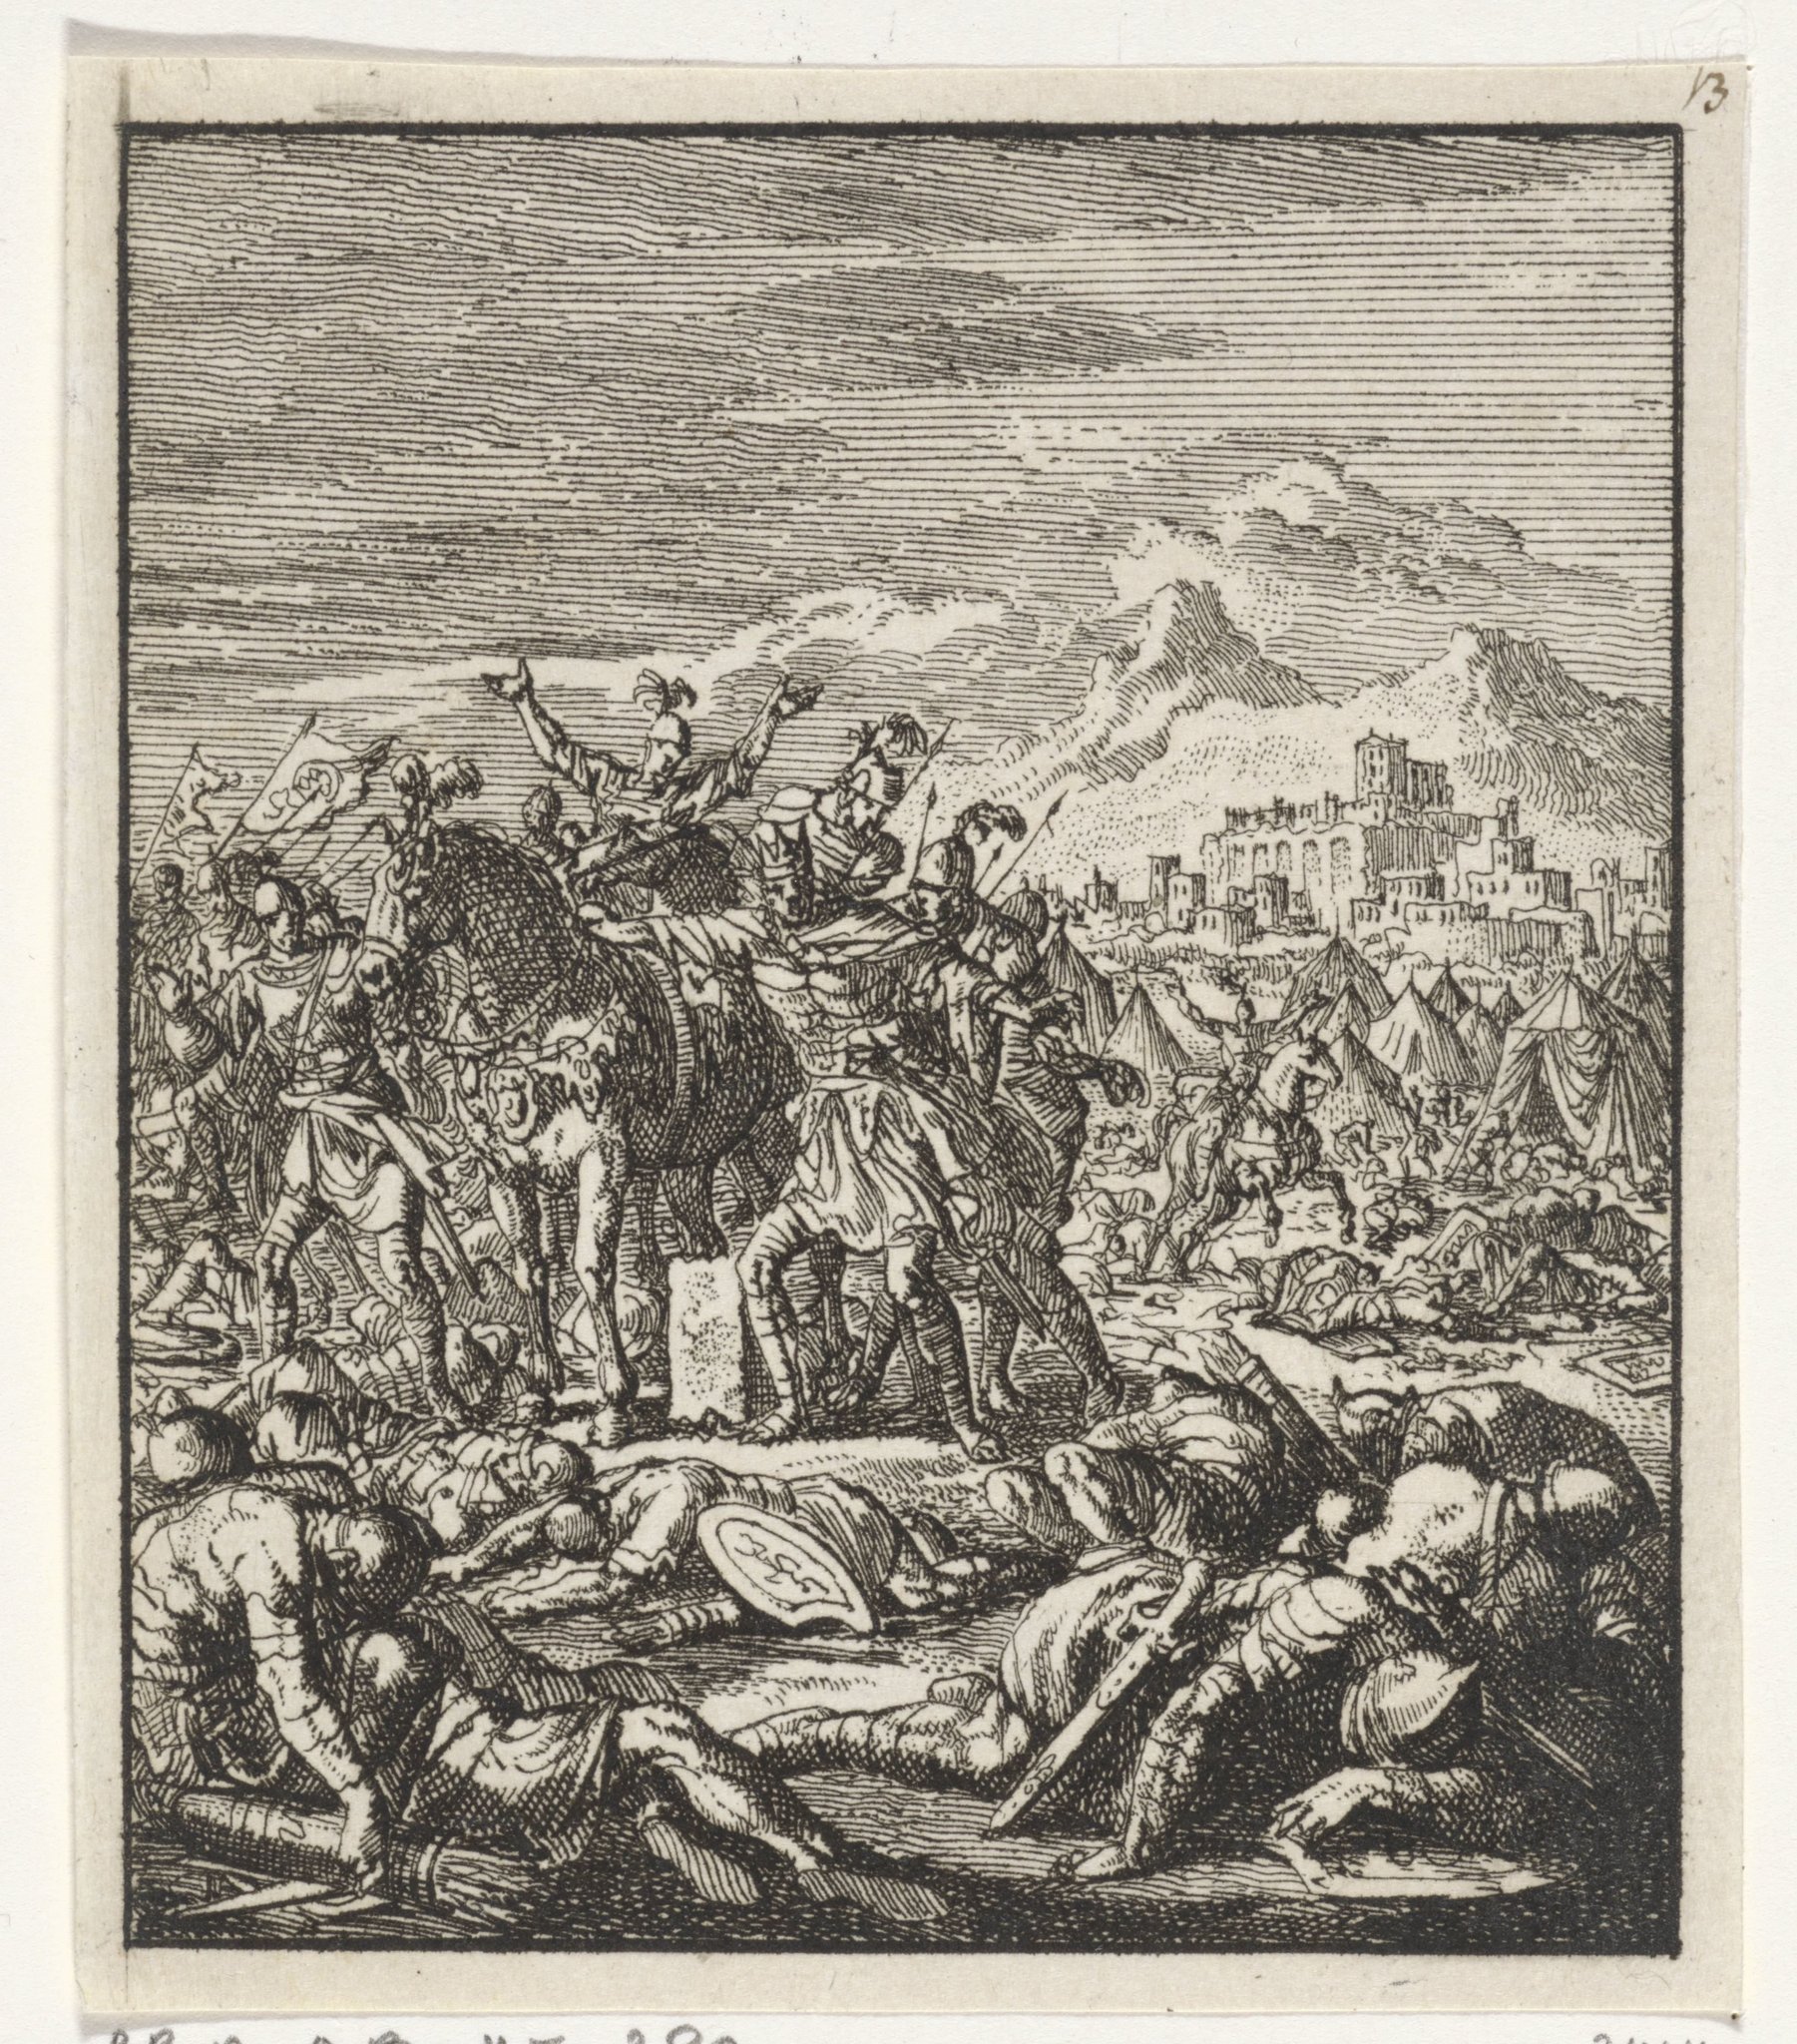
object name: print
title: Hizkia vindt het verslagen leger van Sanherib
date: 1706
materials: paper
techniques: etching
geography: amsterdam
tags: at night, an angel of the lord decimates the assyrian camp: 185.000 soldiers are killed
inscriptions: collector's mark: Lugt 2228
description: Illustratie voor: Schabaalje, Jean Philipsz. De vermeerderde lust-hof des gemoeds. Amsterdam: Jan Rieuwertsz. (II) en Barent Visscher, 1706, p. 245.